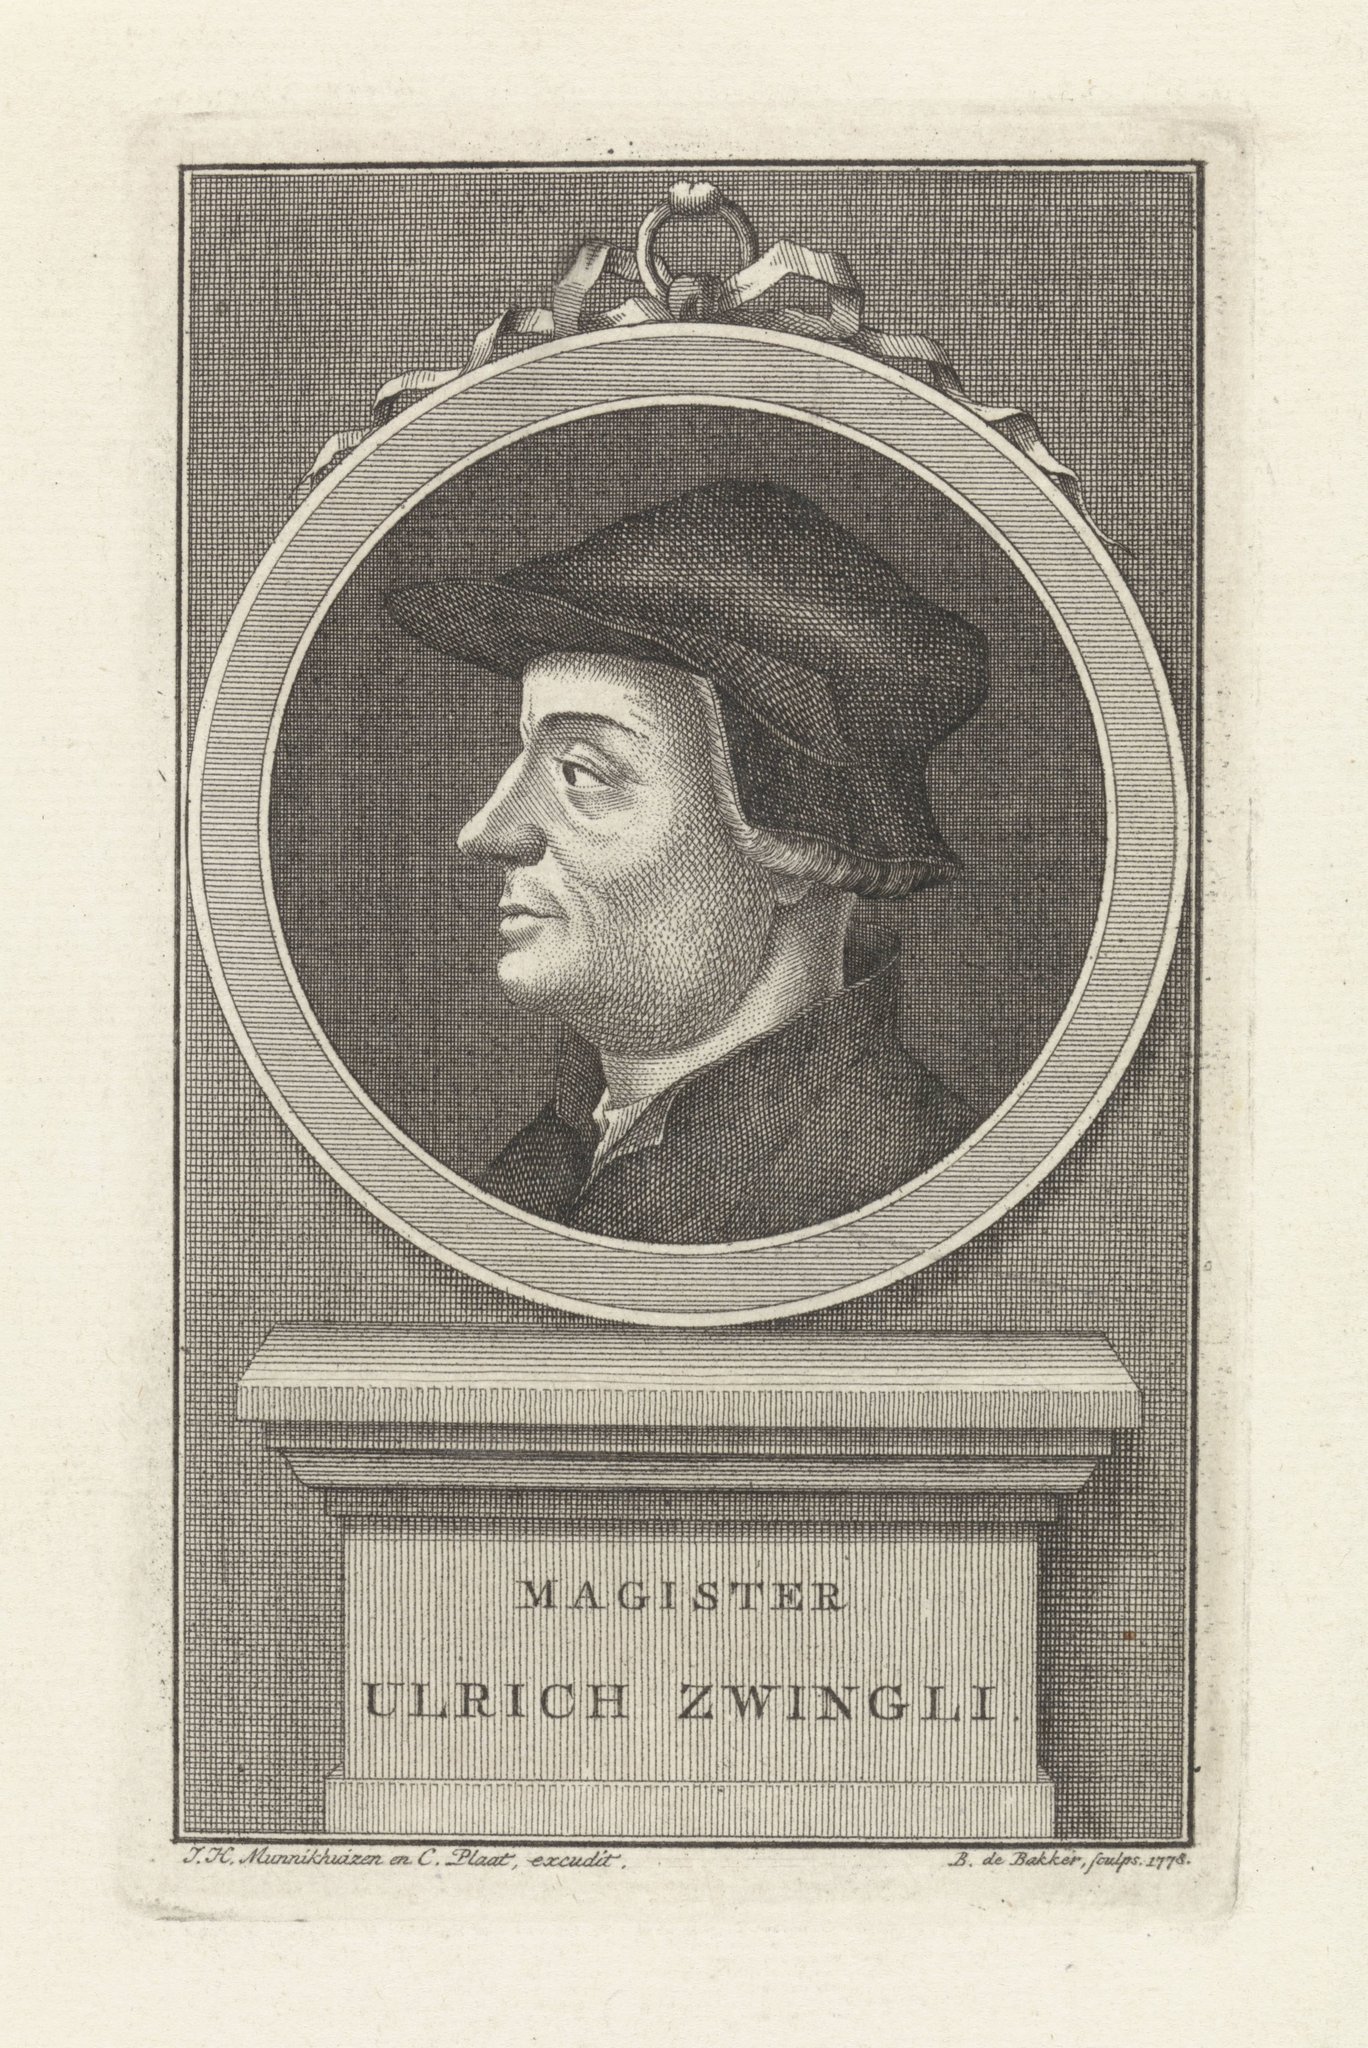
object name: print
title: Magister Ulrich Zwingli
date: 1778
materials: paper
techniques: engraving, etching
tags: clergyman, historical persons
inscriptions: collector's mark: Lugt 2228